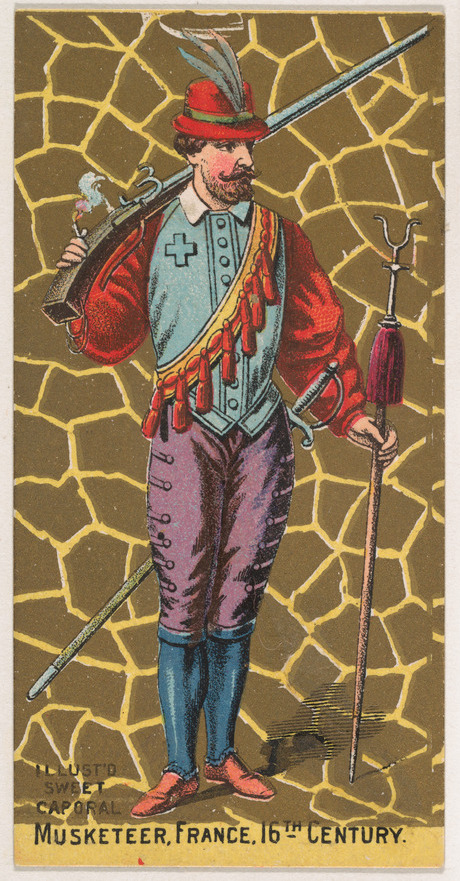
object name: print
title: Musketeer, France, 16th Century, from the Military Series (N224) issued by Kinney Tobacco Company to promote Sweet Caporal Cigarettes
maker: kinney brothers tobacco company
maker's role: publisher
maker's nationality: american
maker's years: 1869-2011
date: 1888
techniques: color lithograph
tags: military,firearms,men